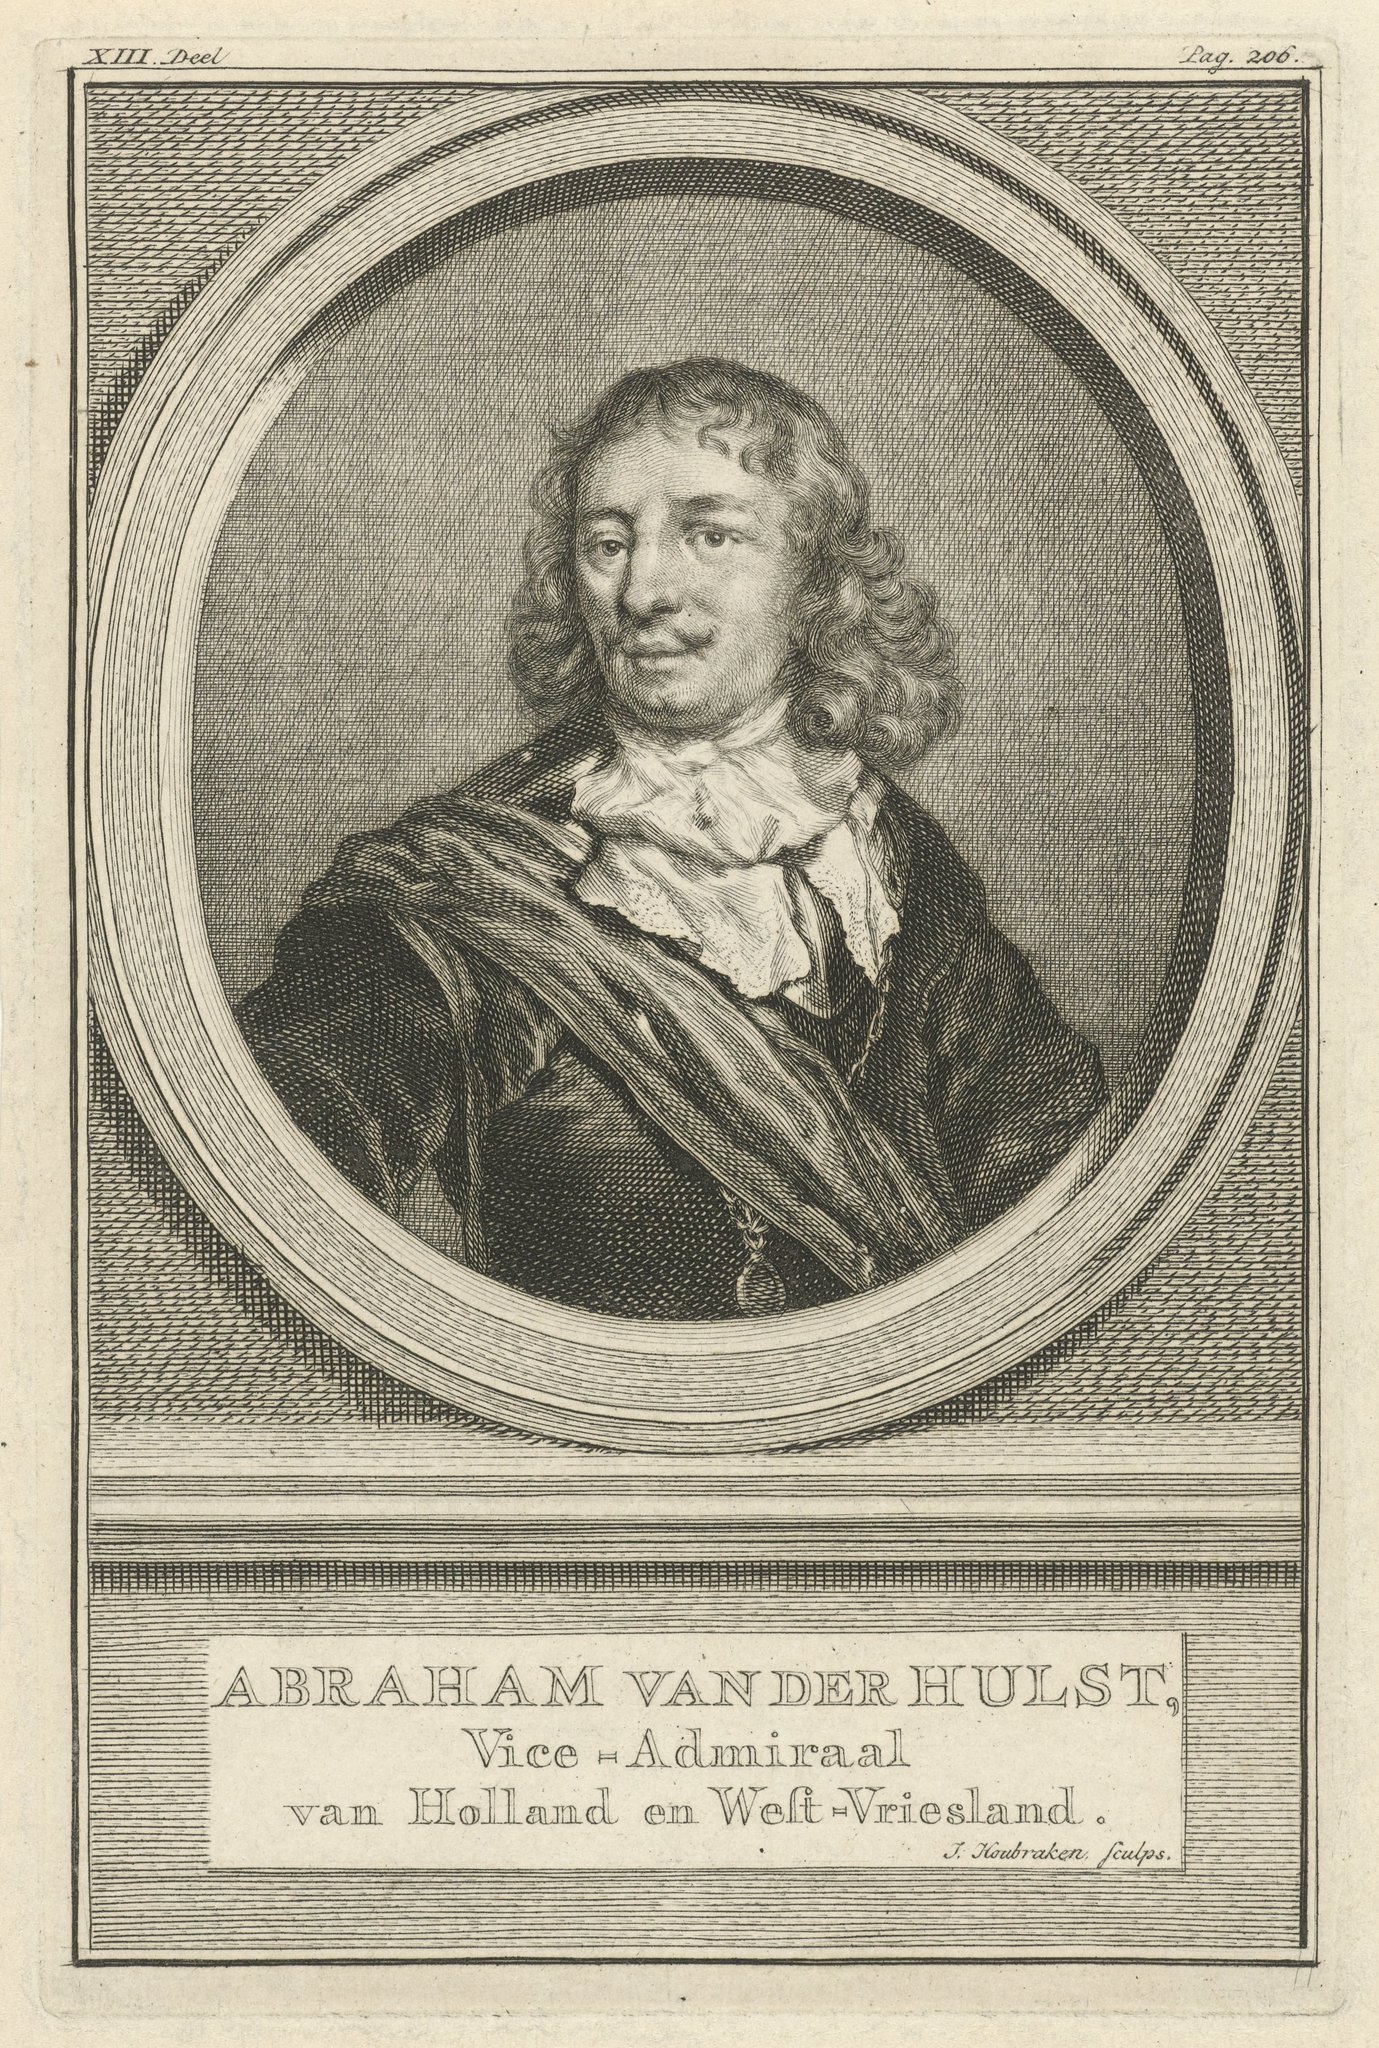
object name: print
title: Abraham van der Hulst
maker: jacob houbraken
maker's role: draughtsman, print maker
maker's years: 1698-1780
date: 1749-1759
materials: paper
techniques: engraving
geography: amsterdam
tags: admiraal, abraham van der hulst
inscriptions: collector's mark: Lugt 2228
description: Prent ook gebruikt in: Jan Wagenaar, Vaderlandsche historie, vervattende de geschiedenissen der nu Vereenigde Nederlanden, inzonderheid die van Holland (...), 21 delen. Amsterdam, Johannes Allart, 1790-96.